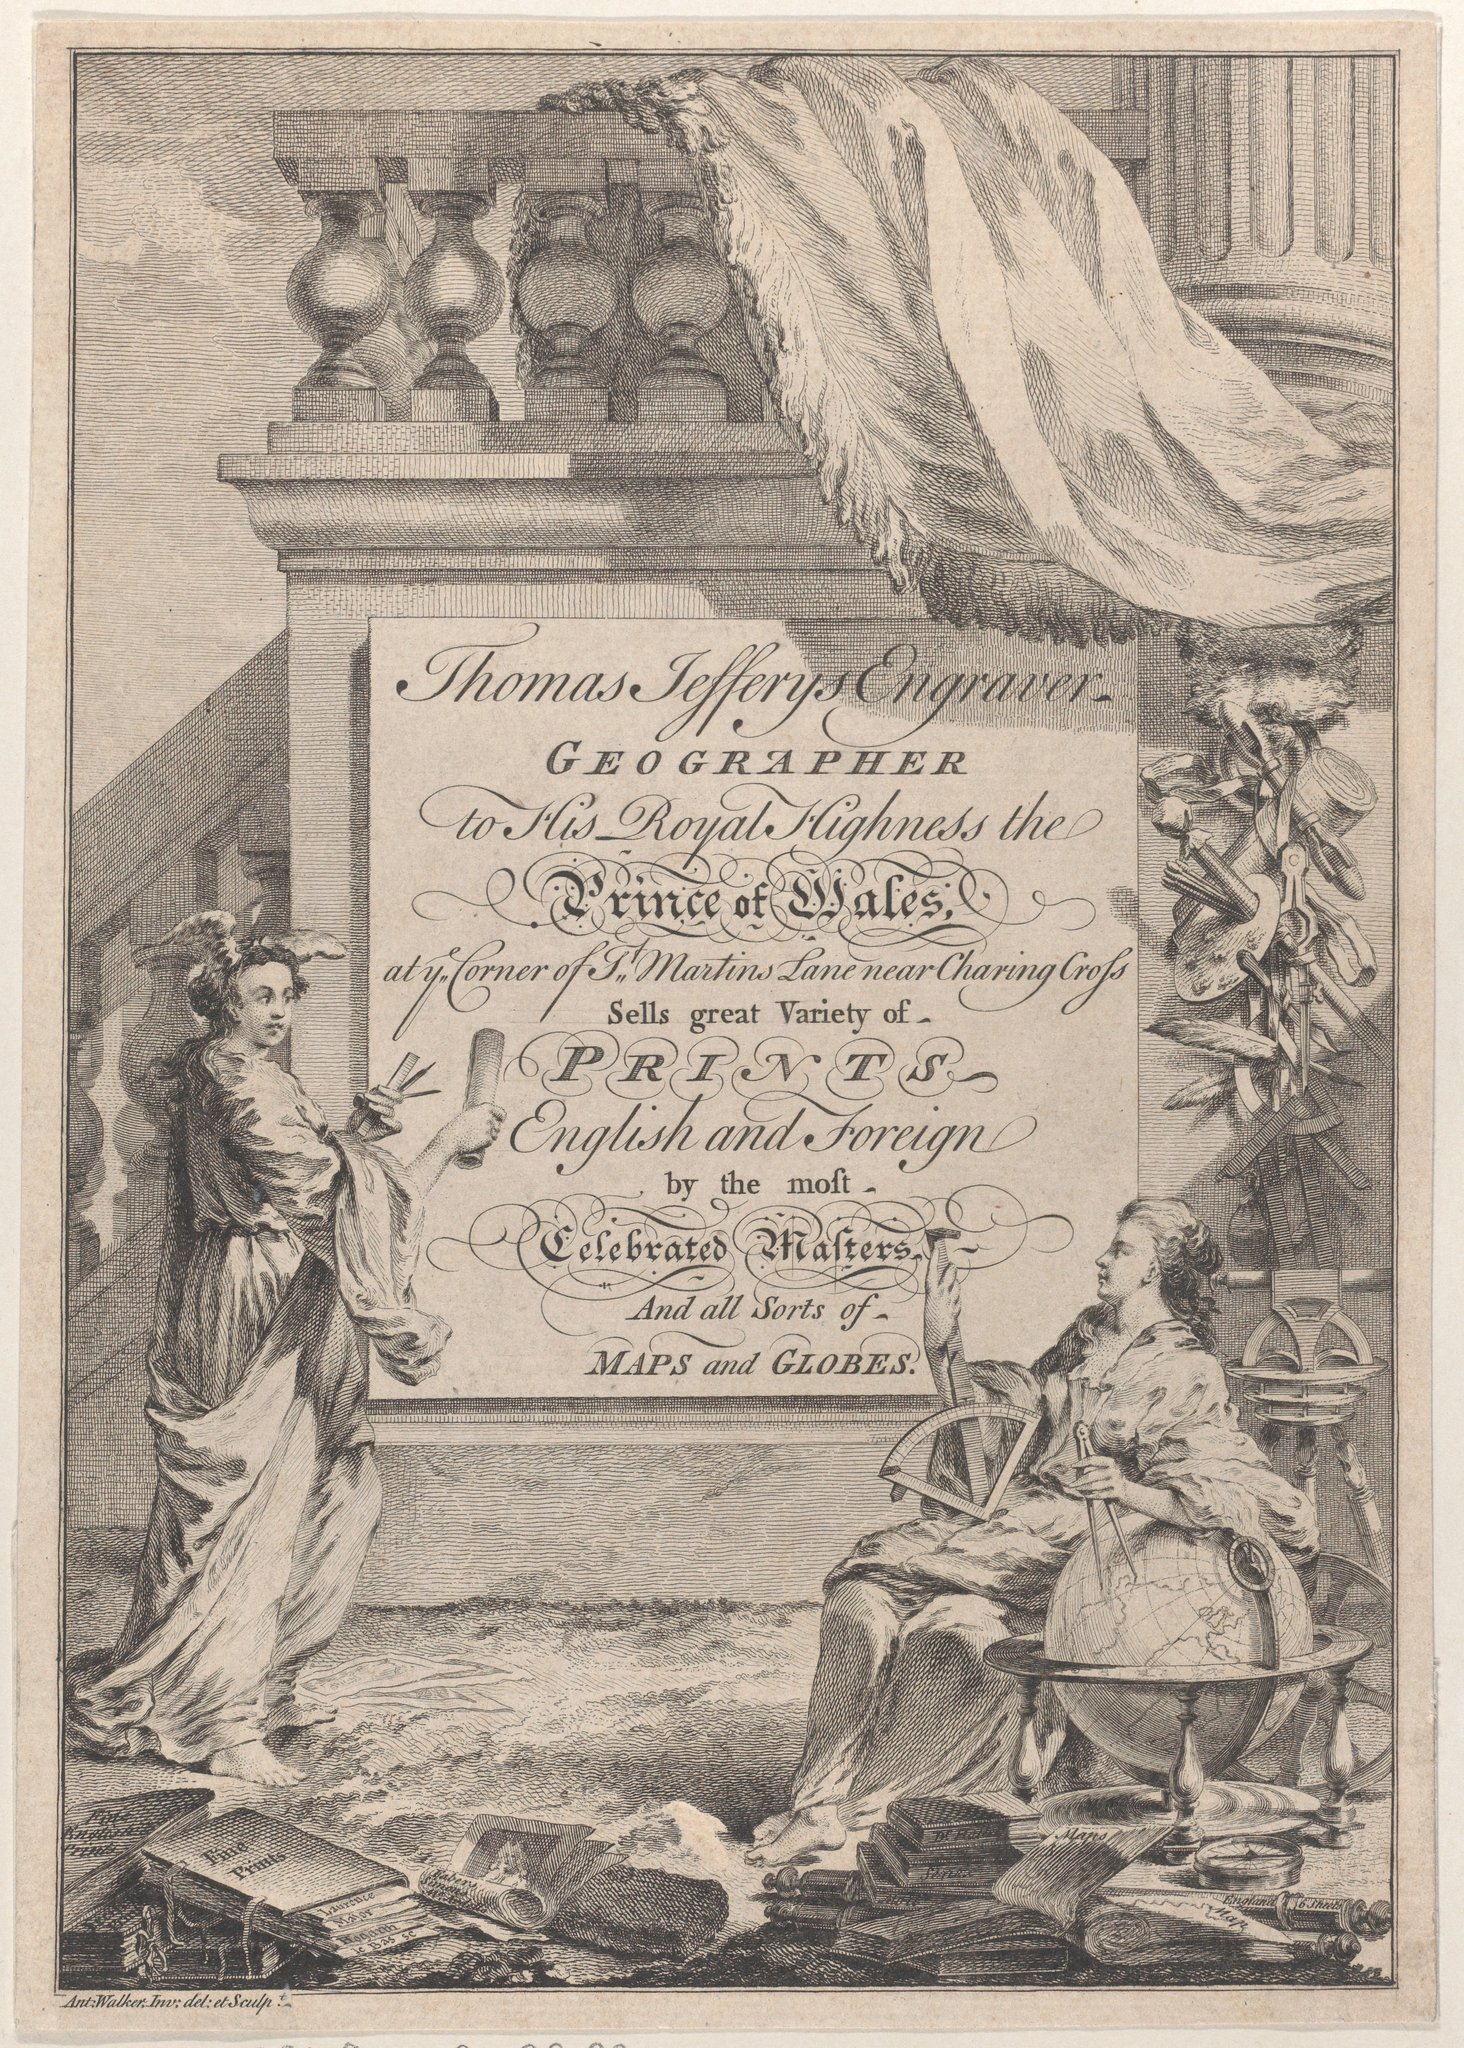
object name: print, trade card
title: Trade Card for Thomas Jeffreys, Engraver, Geographer, and Printseller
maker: anthony walker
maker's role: artist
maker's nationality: british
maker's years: 1726-1765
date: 1701-1800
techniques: engraving